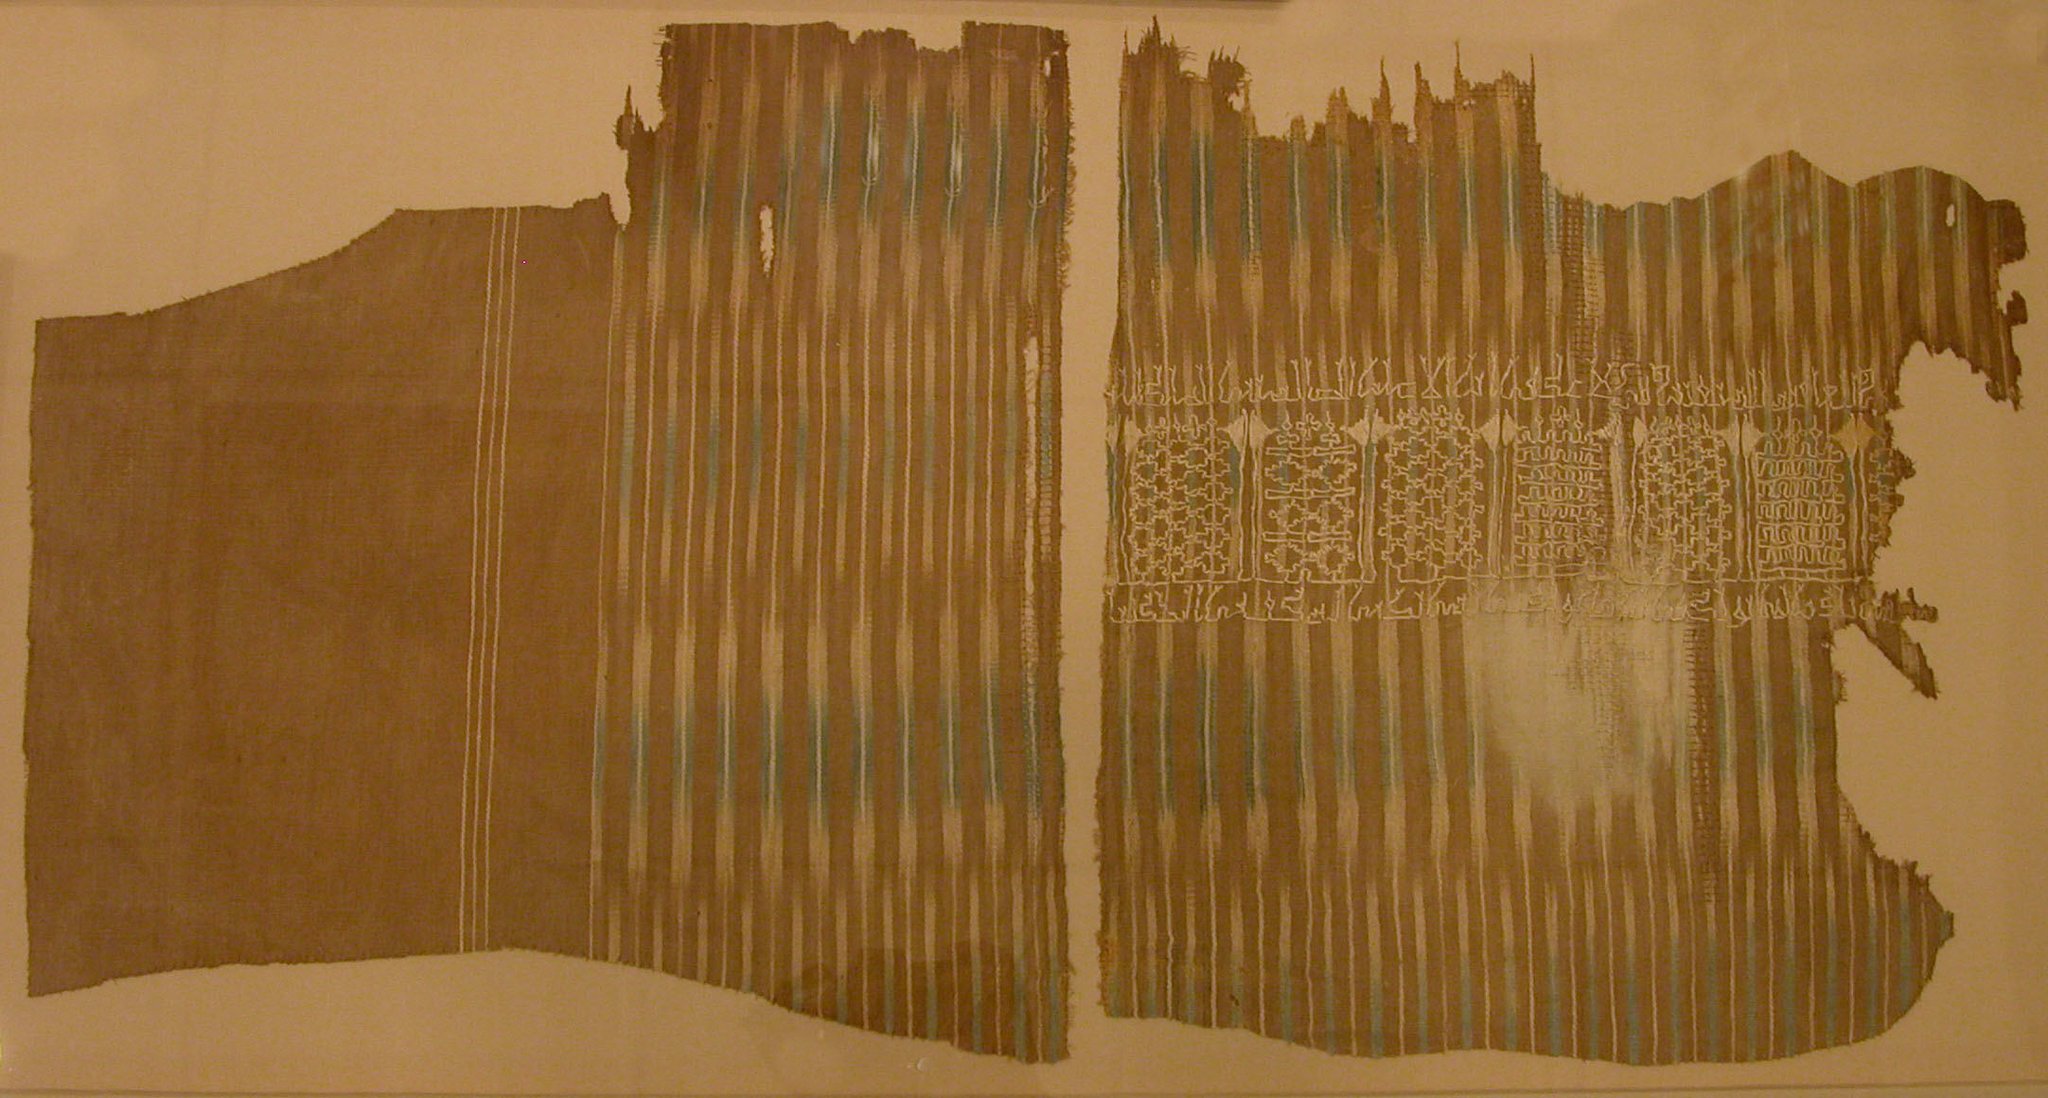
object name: textile fragment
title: Fragment of a Mantle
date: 901-1000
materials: cotton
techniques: dyeing, embroidery, weave, resist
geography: yemen